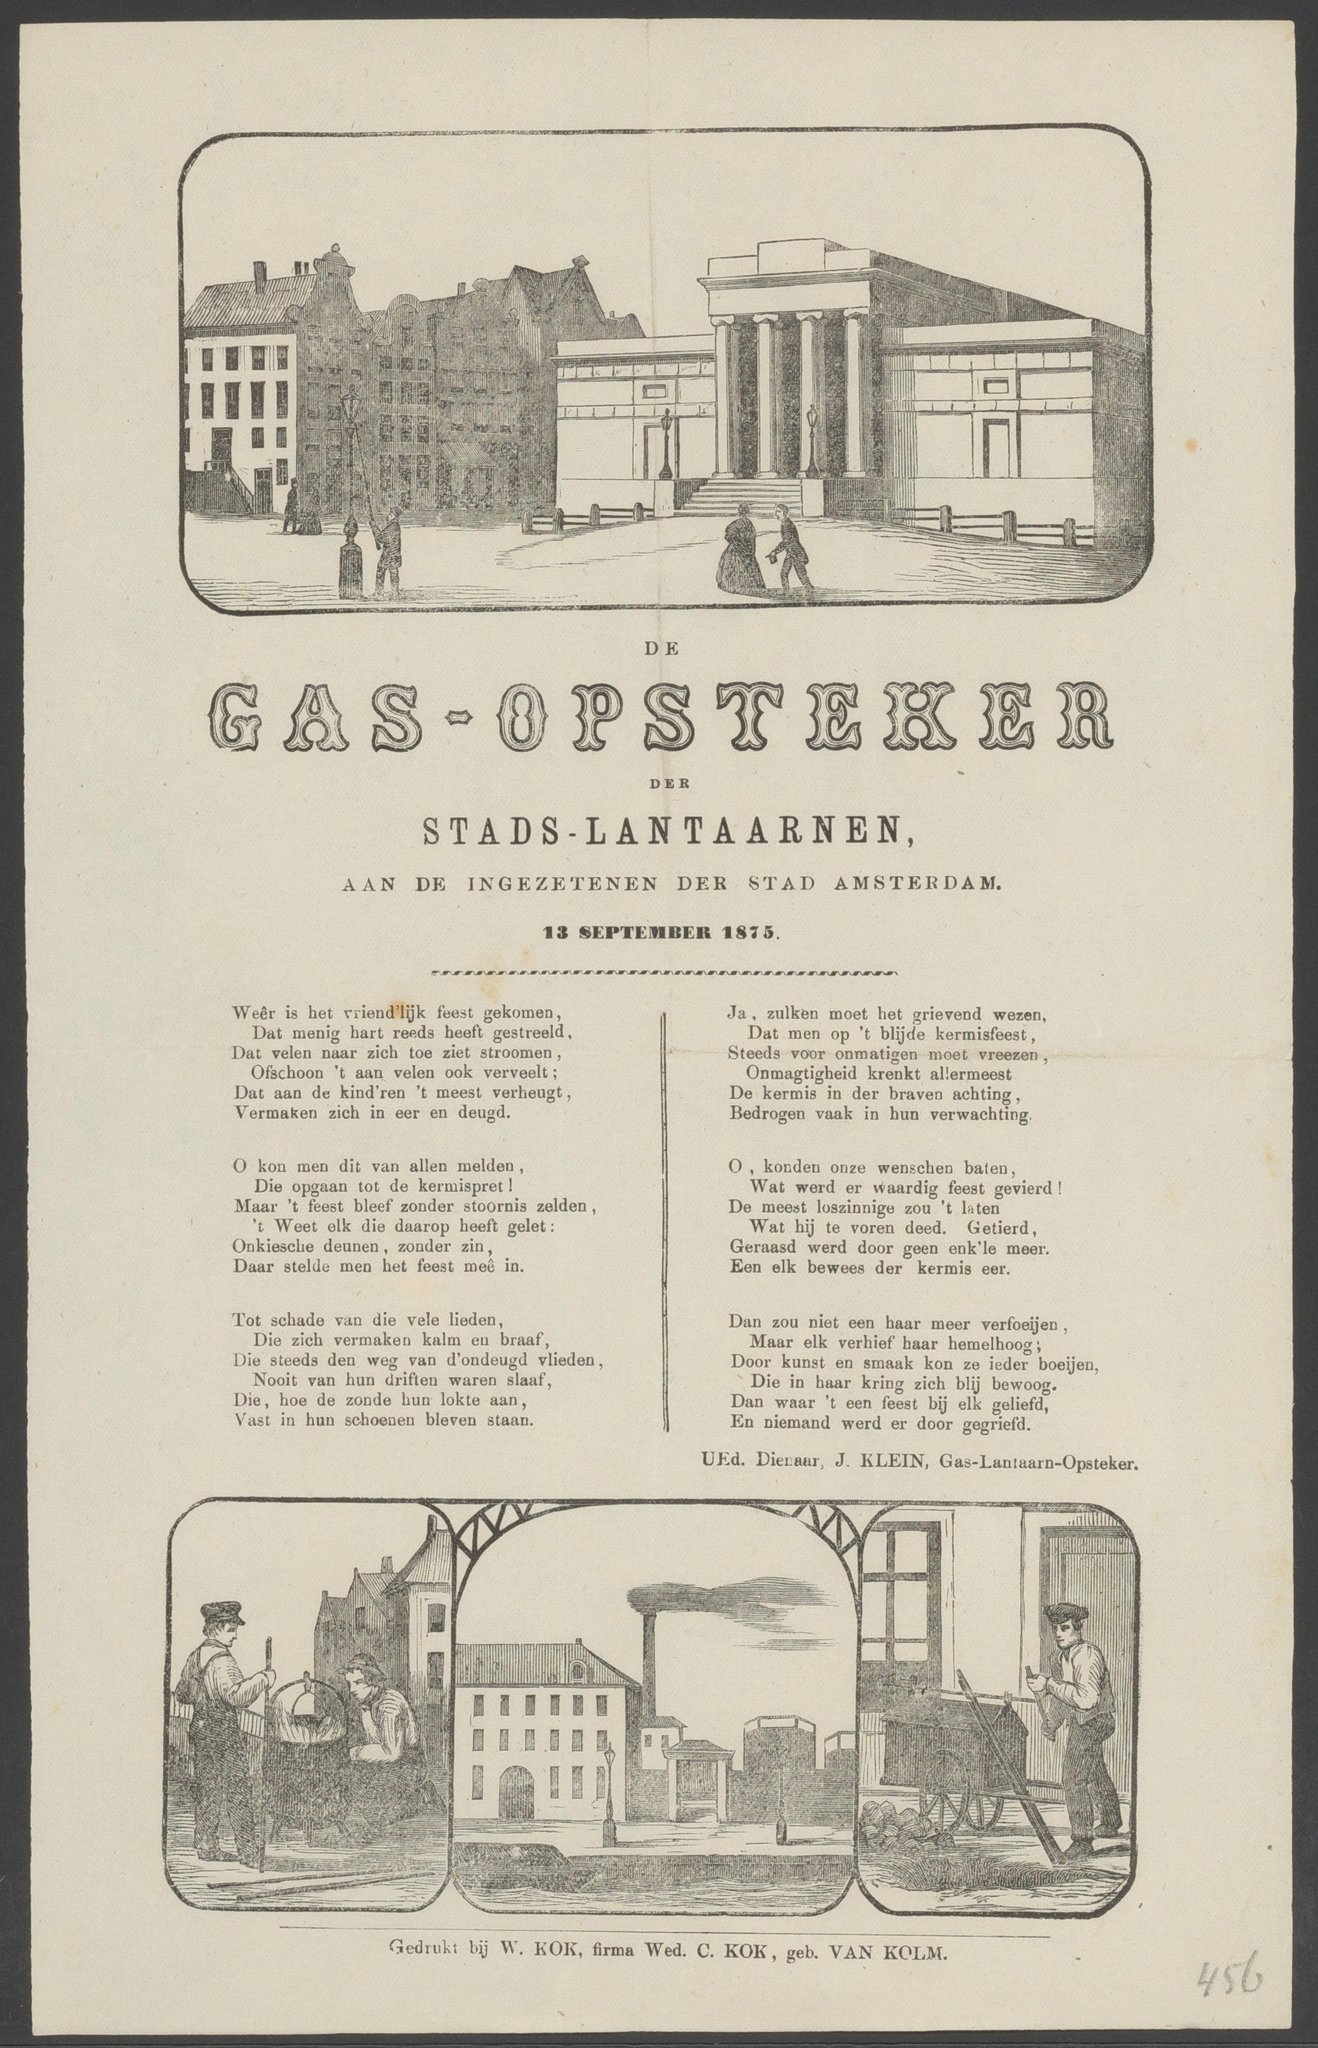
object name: print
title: Kermiswens van de gaslantaarnopstekers van Amsterdam voor het jaar 1875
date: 1875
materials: paper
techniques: letterpress printing, engraving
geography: amsterdam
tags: gas-lamp, gas supply, digging (industrial process), street lighting, amsterdam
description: Kermiswens van de Amsterdamse gaslantaarnopstekers voor het jaar 1875. Centraal een vers in twee kolommen. Bovenaan de Dam met de beurs van Zocher te Amsterdam. Onderaan de Hollandsche Gasfabriek en twee gasfitters aan het werk. Van de gaslantaarnopsteker: J. Klein. Onderwerpsrubrieken binnen de Atlas Zeden en Gewoonten: Zeden en gewoonten in engeren zin, Volksleven, Volksbladen, Nieuwjaars- en Kerstwenschen, Amsterdam.